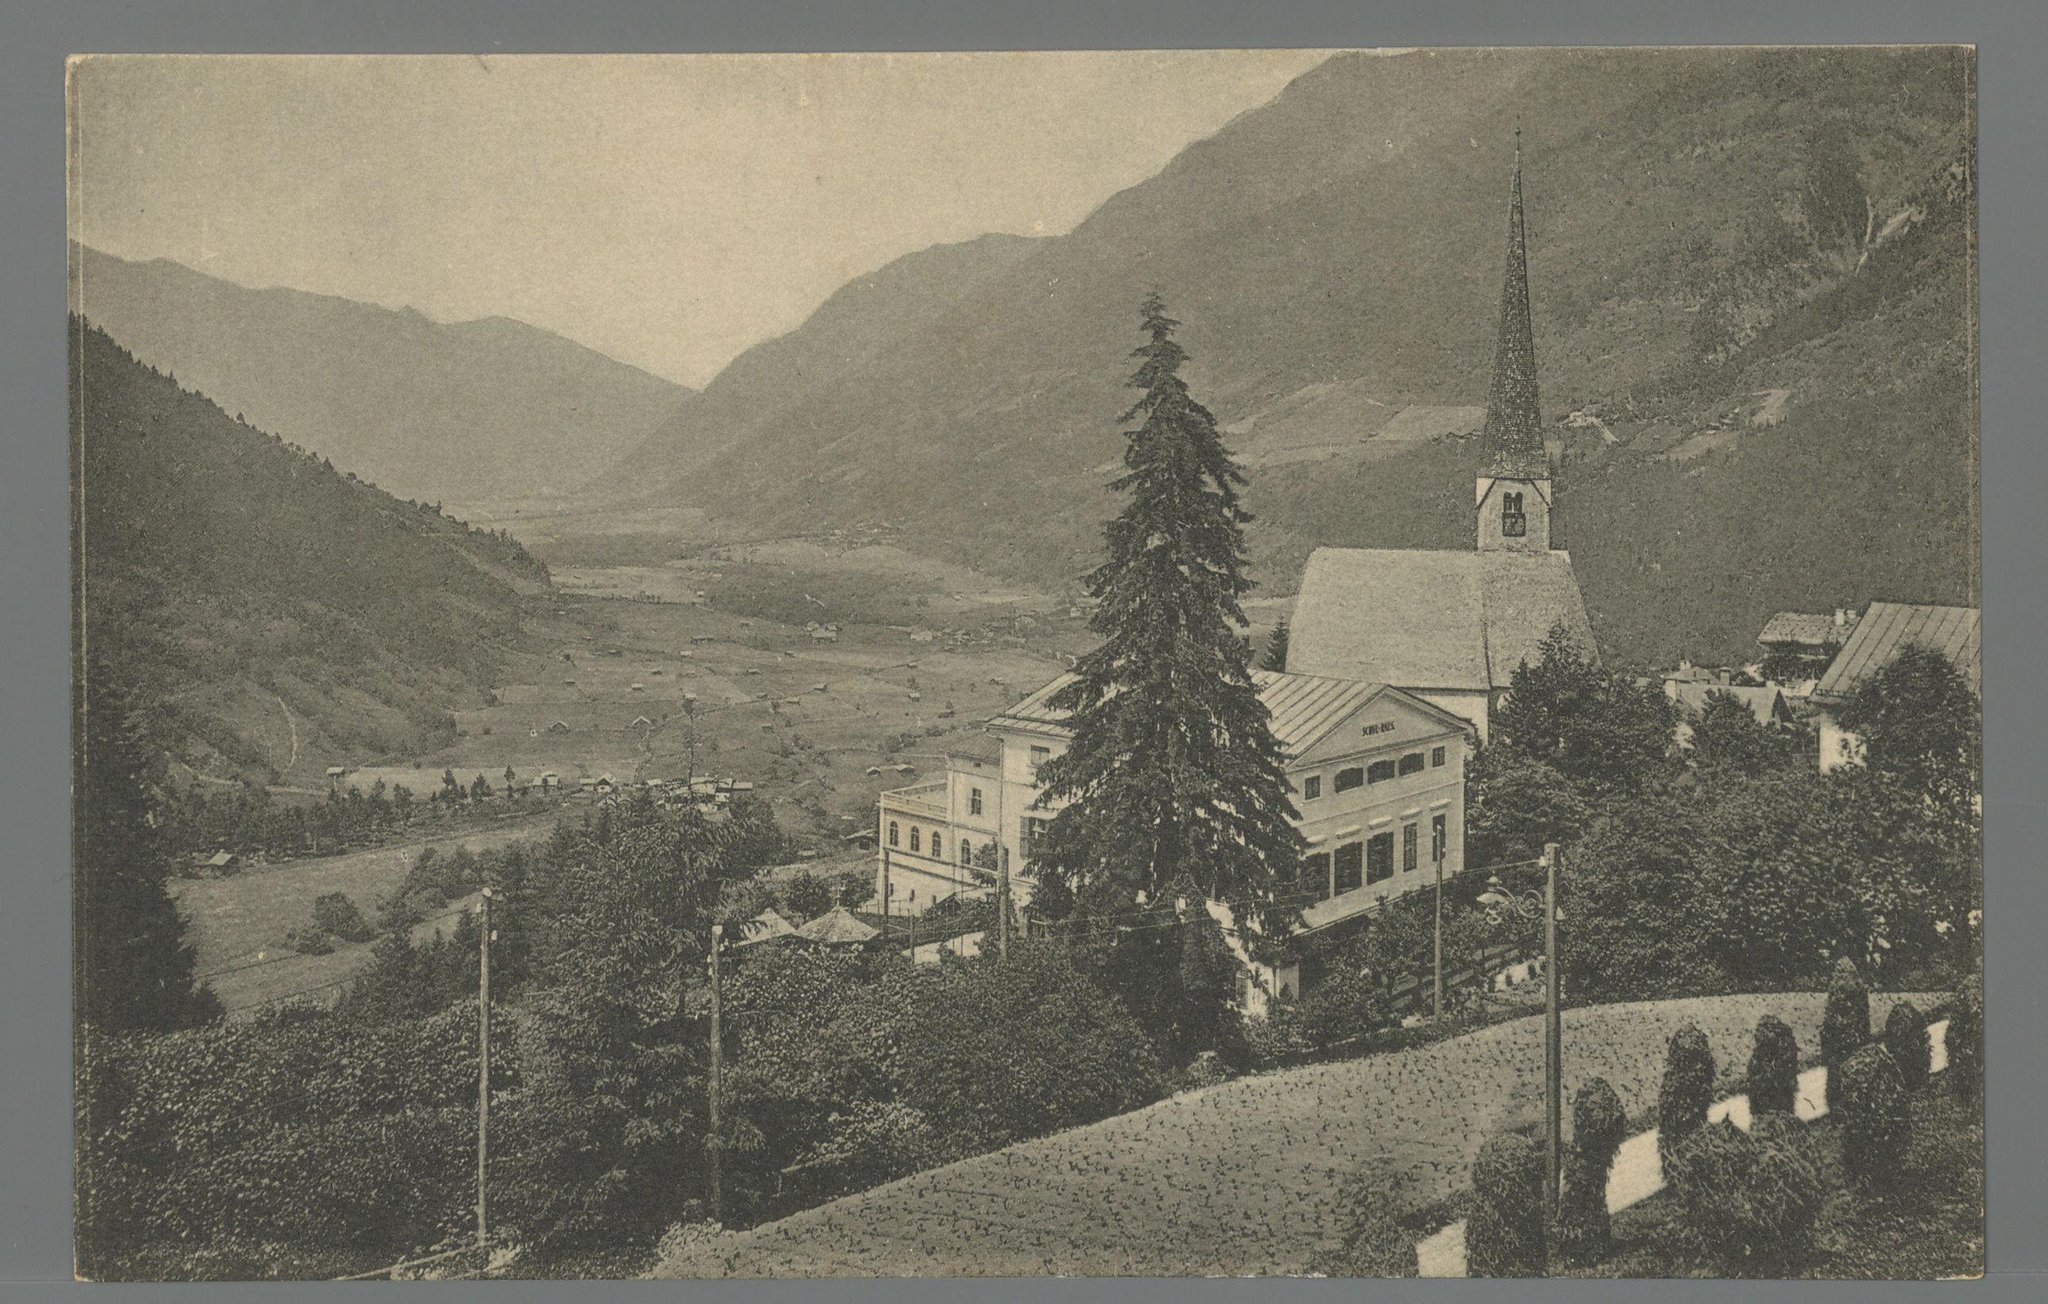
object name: photomechanical print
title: Bad Gastein, St. Nicolaus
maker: Anonymous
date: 1904-1907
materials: cardboard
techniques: photograph, writing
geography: vienna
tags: dale, valley, church (exterior)